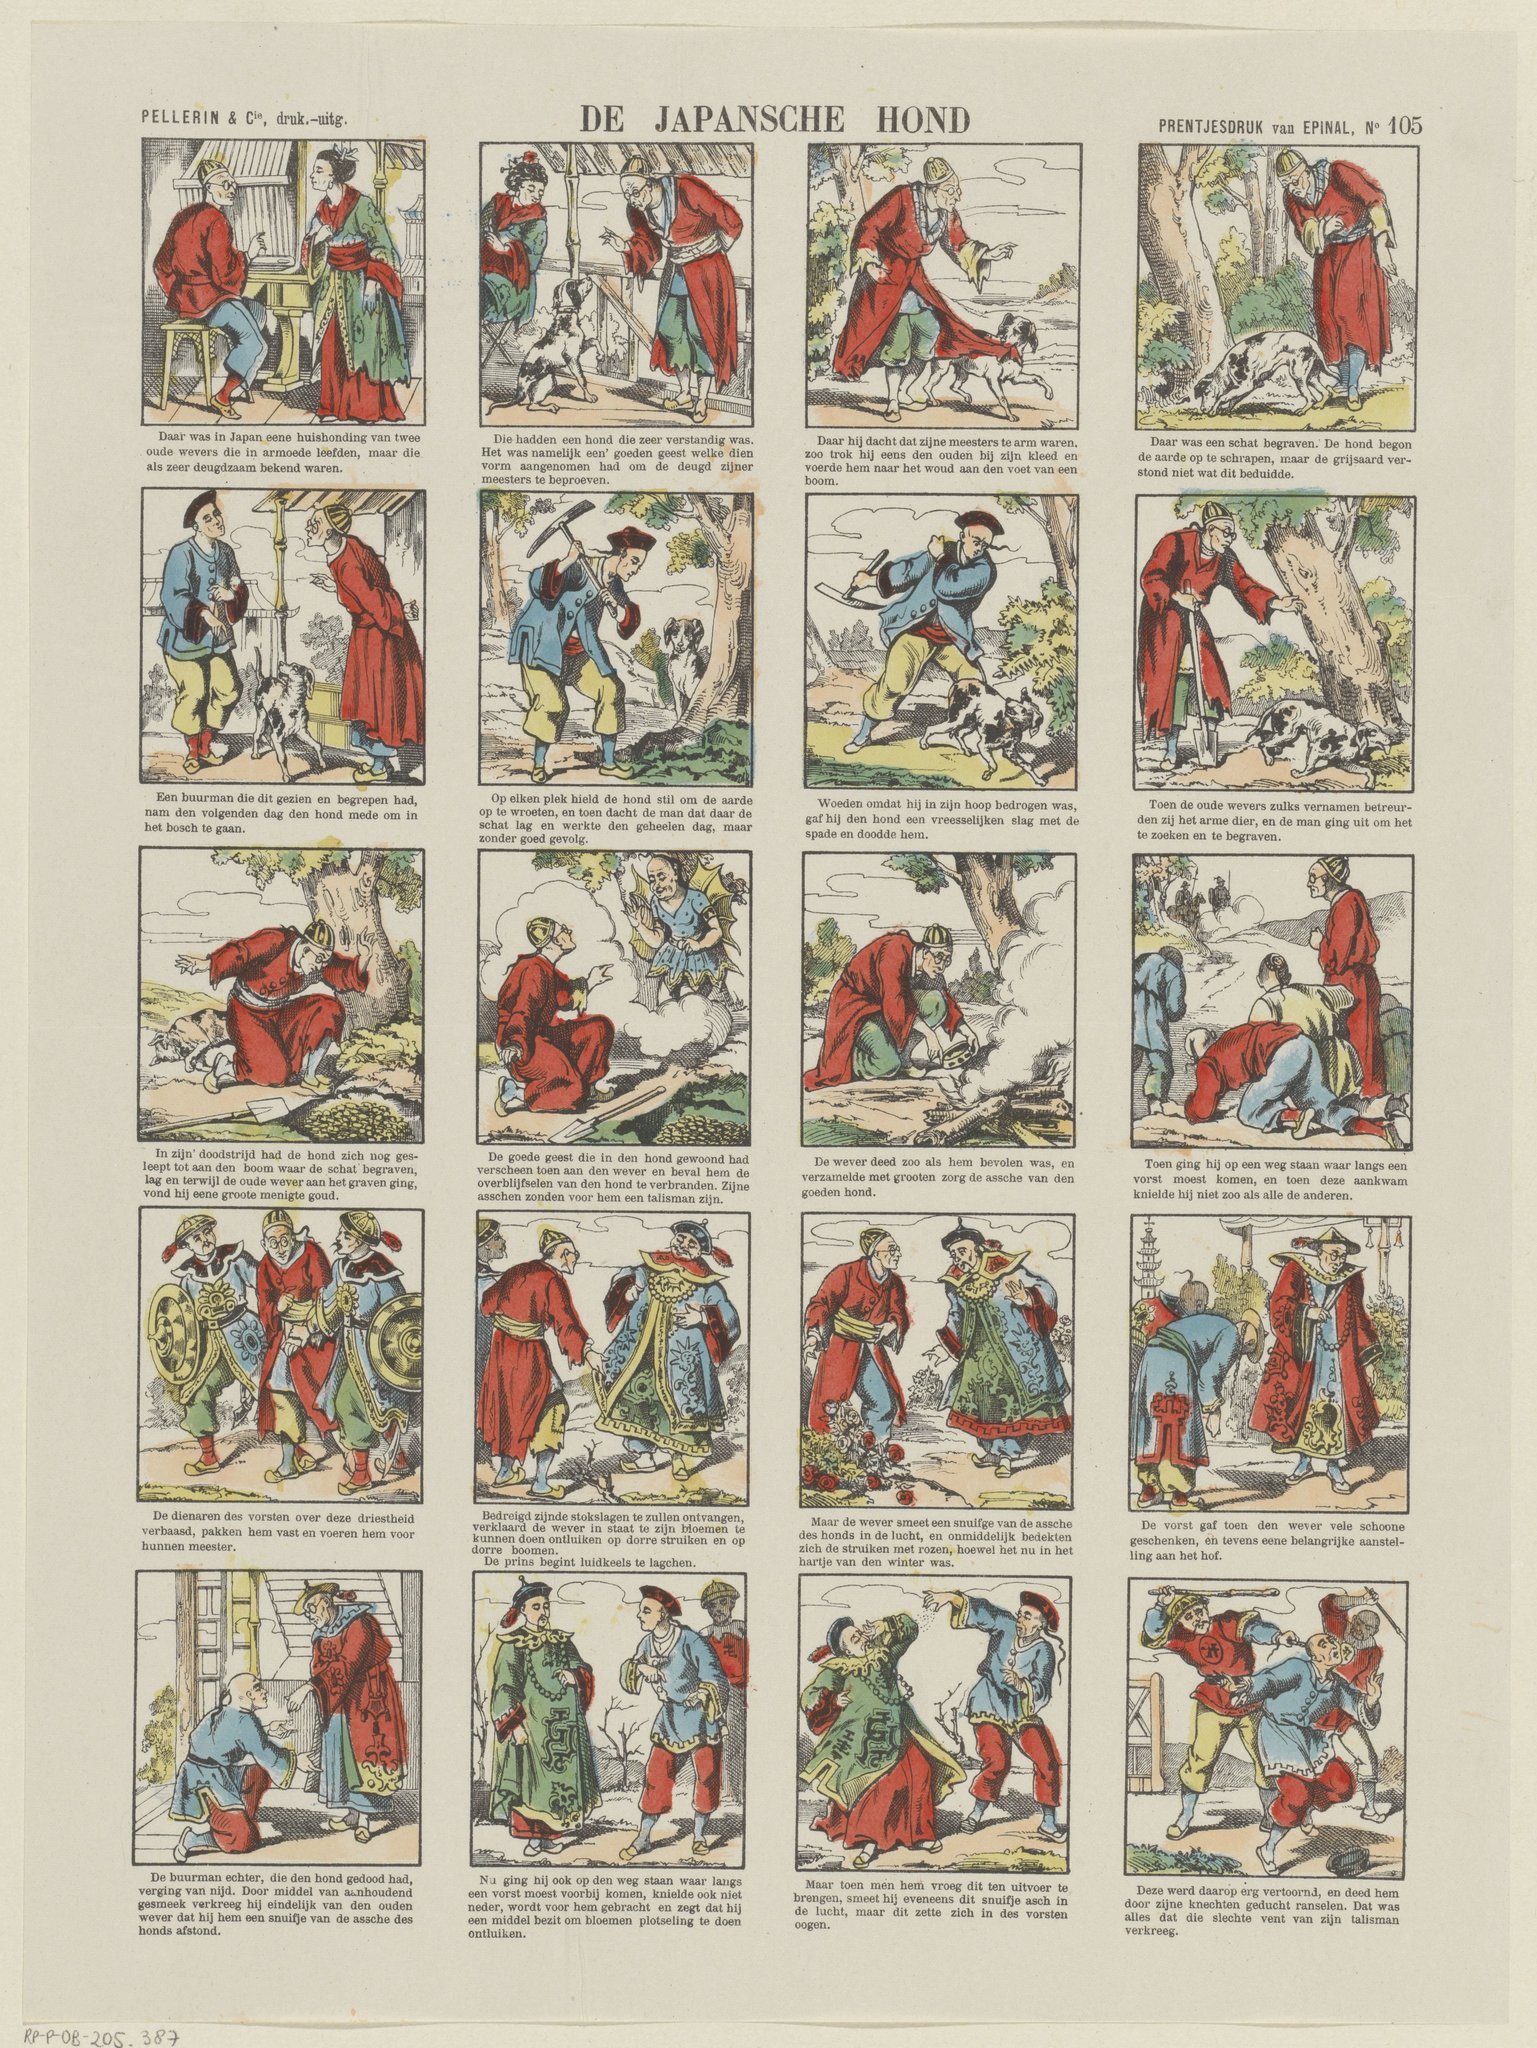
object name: print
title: Prentjesdruk van Epinal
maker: Anonymous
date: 1902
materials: paper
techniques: colour, letterpress printing, lithograph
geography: epinal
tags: magic, supernaturalism, occultism, tales and fairy tales, digging for or finding of treasure, dog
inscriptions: collector's mark: Lugt 2760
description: Blad met 20 voorstellingen over het magische as van een Japanse hond. Onder elke afbeelding een onderschrift. Genummerd rechtsboven: No 105.